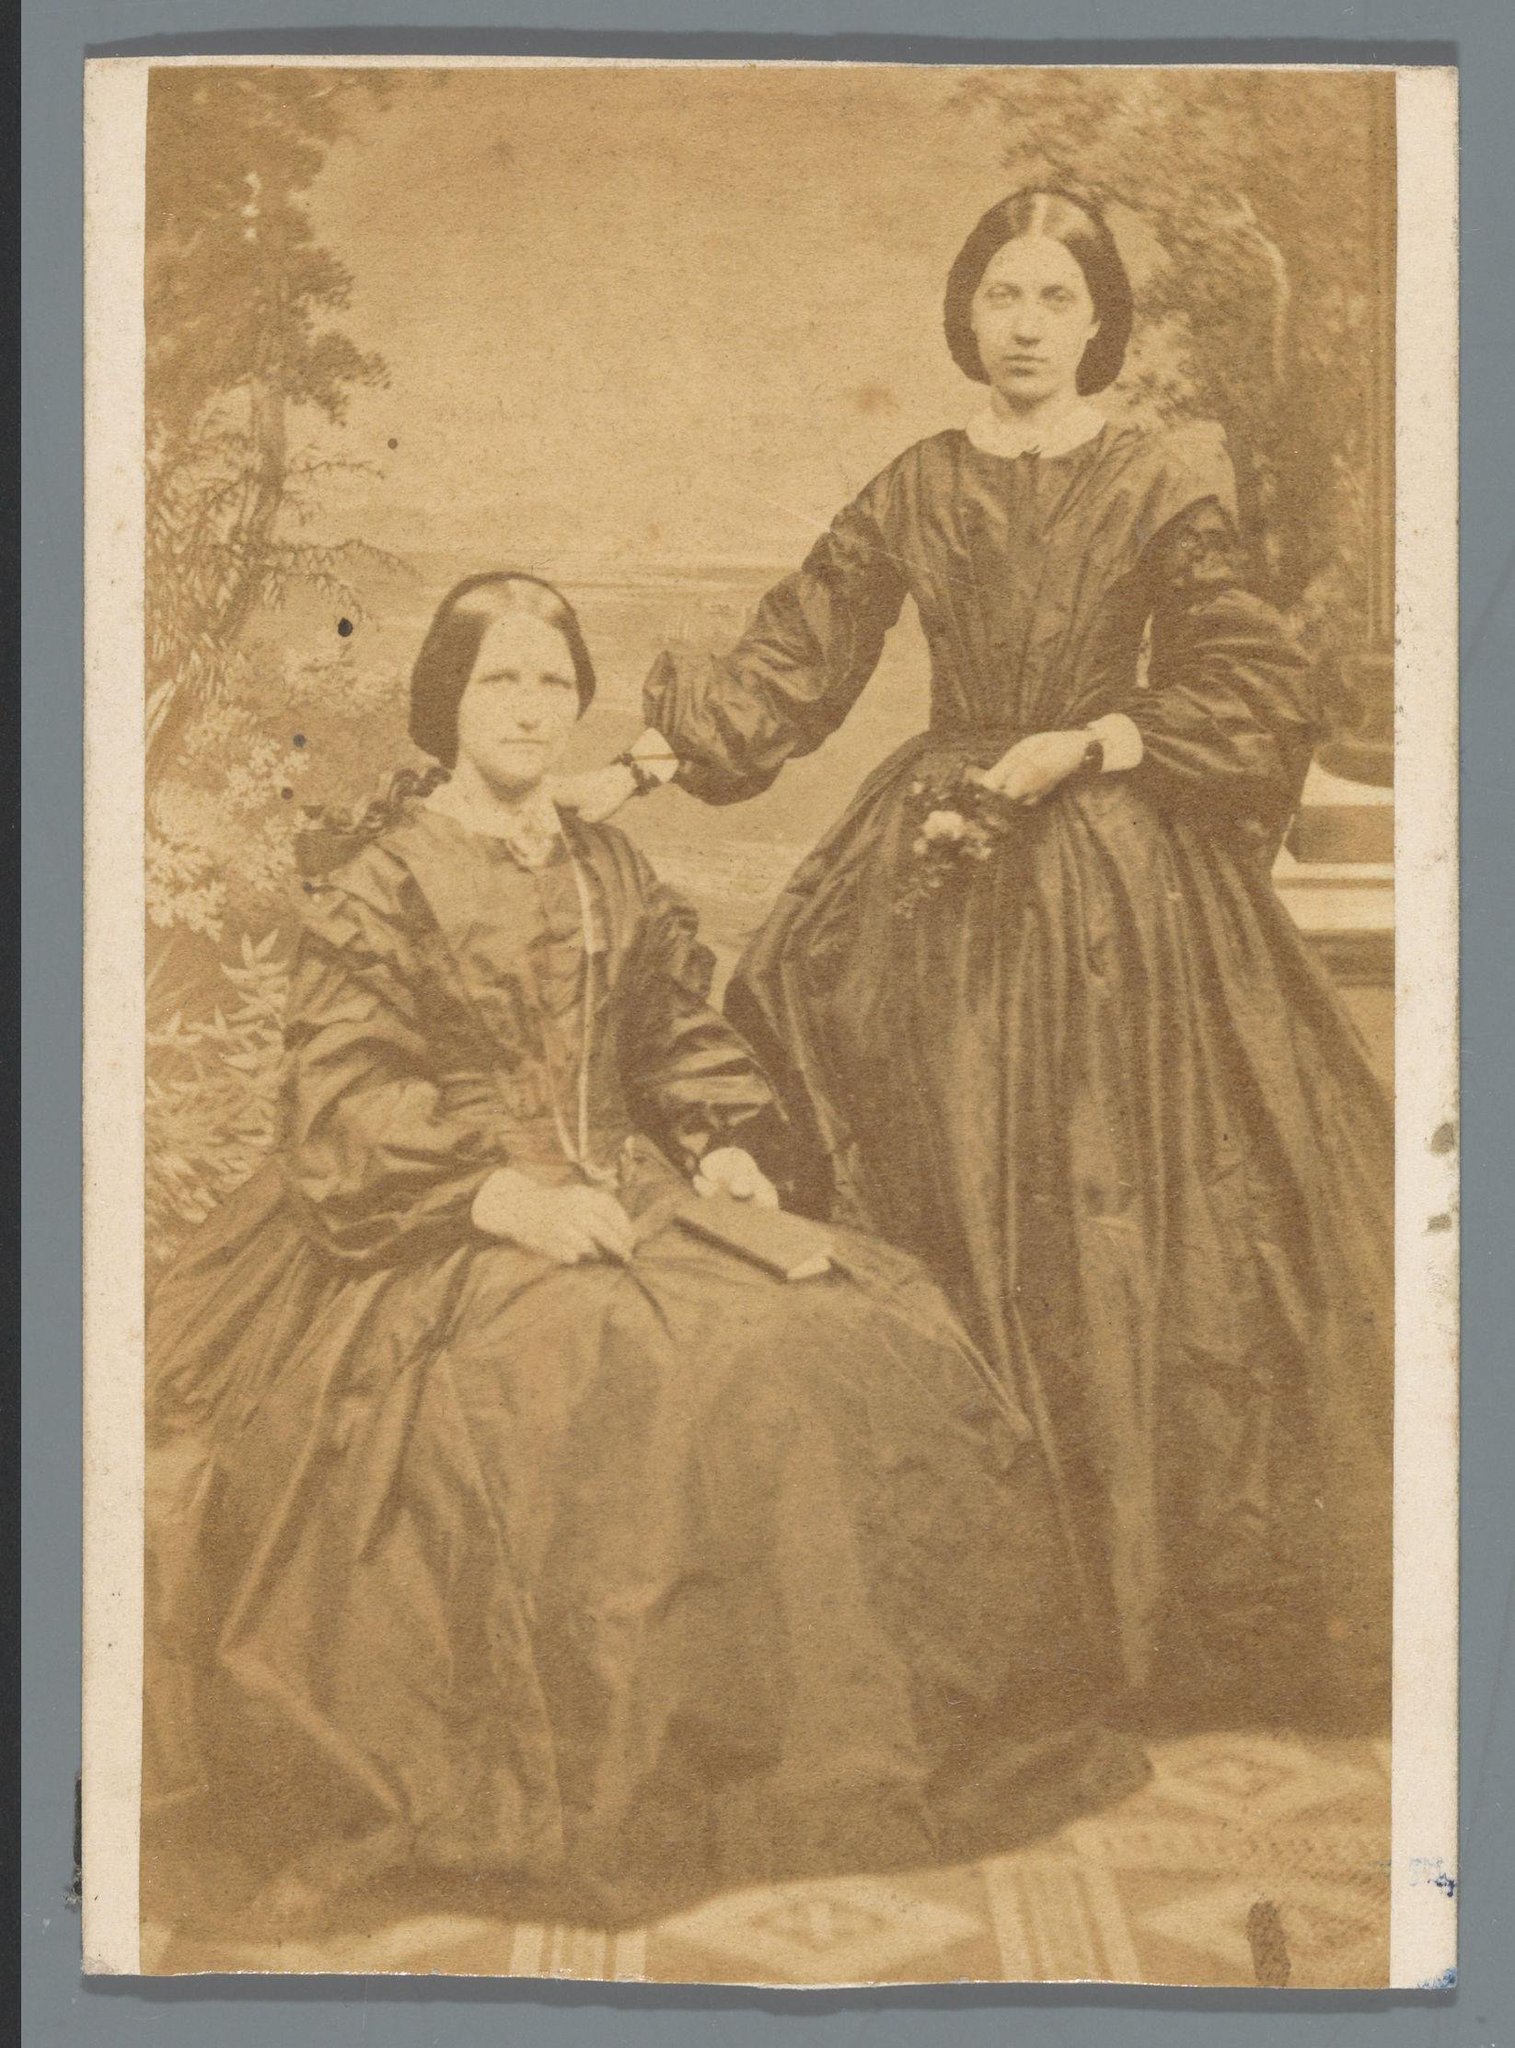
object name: carte de visite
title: Portret van twee onbekende vrouwen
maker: john bateman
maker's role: fotograaf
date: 1855-1870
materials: cardboard, paper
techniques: albumen print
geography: canterbury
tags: adult woman, hand on shoulder (friends), anonymous historical person portrayed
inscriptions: inscription: ‘51, St. George's Street, Canterbury/ J. Bateman,/ Photographer.’